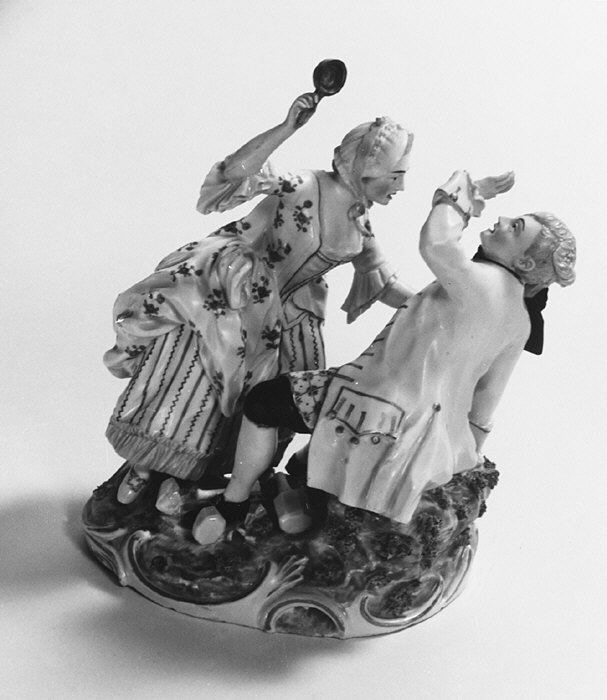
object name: group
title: Marital discord (one of a pair)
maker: frankenthal porcelain manufactory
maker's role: manufactory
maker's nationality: german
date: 1766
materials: hard paste porcelain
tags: men,women